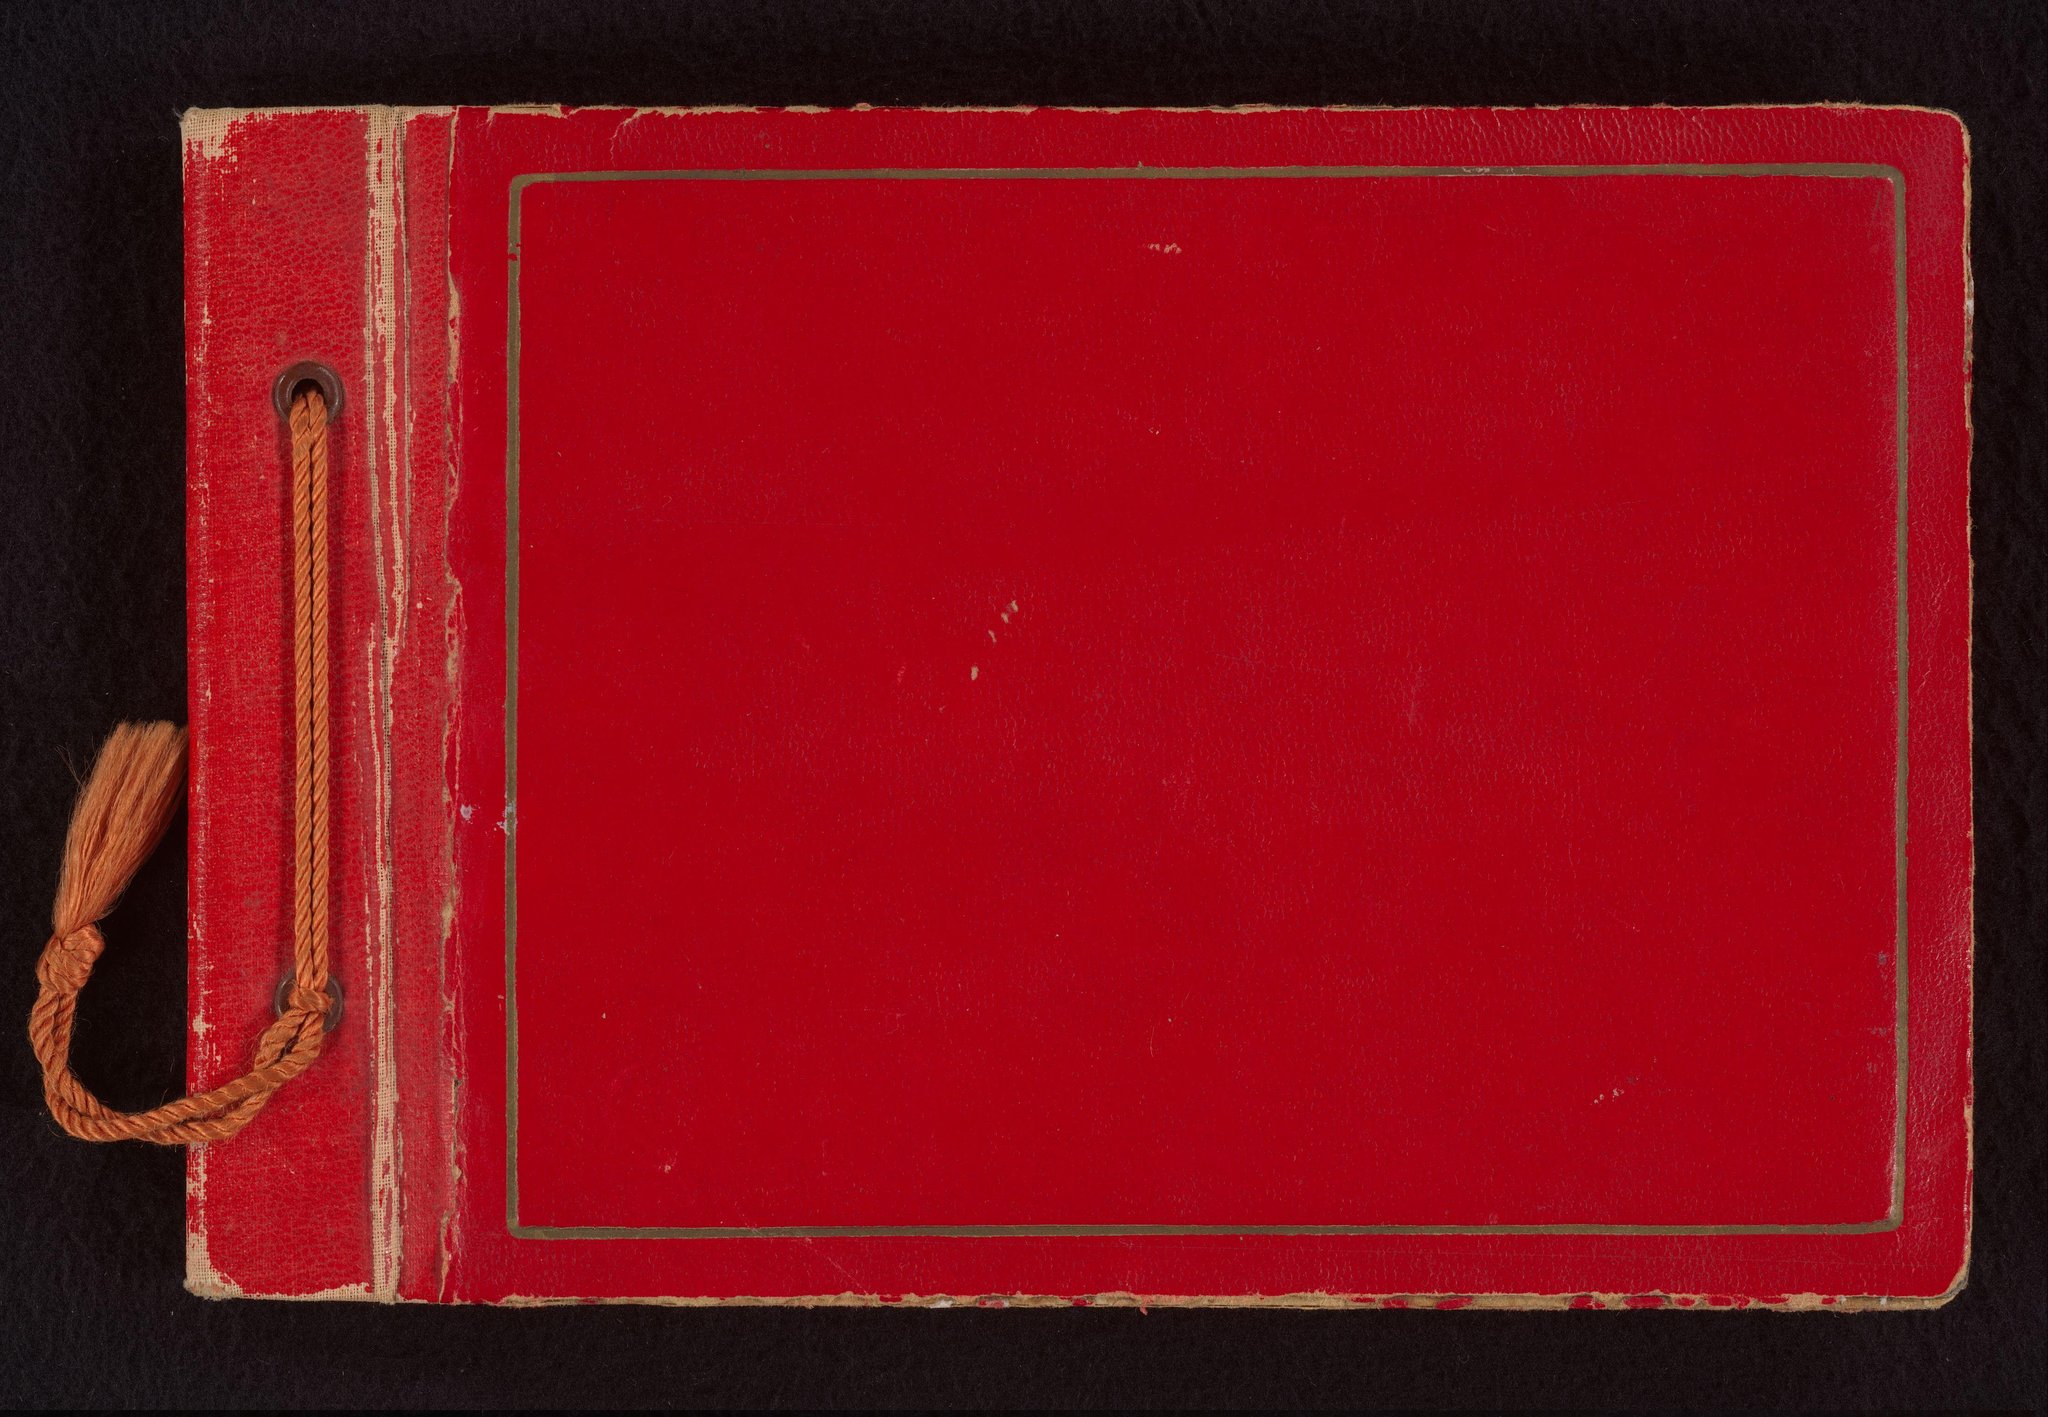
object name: slip in album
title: Suriname rond 1930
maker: theodoor brouwers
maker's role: amateurfotograaf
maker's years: 1874-1932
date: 1925-1935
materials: linen, paper, photographic support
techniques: gelatin silver print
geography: suriname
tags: theodoor brouwers, suriname, saint nicholas day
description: Fotoalbum met 18 bladen van bruin papier met in totaal 43 foto's van Suriname rond 1930. Kaft van karton bekleed met linnen met rood imitatieleer. Onderwerpen: landschappen, overheidsgebouwen en ziekenhuisgebouwen, natuur, lokale inwoners, groepsfoto's scouting in Paramaribo, ziekenhuispersoneel en Sinterklaasviering in een ziekenhuis.